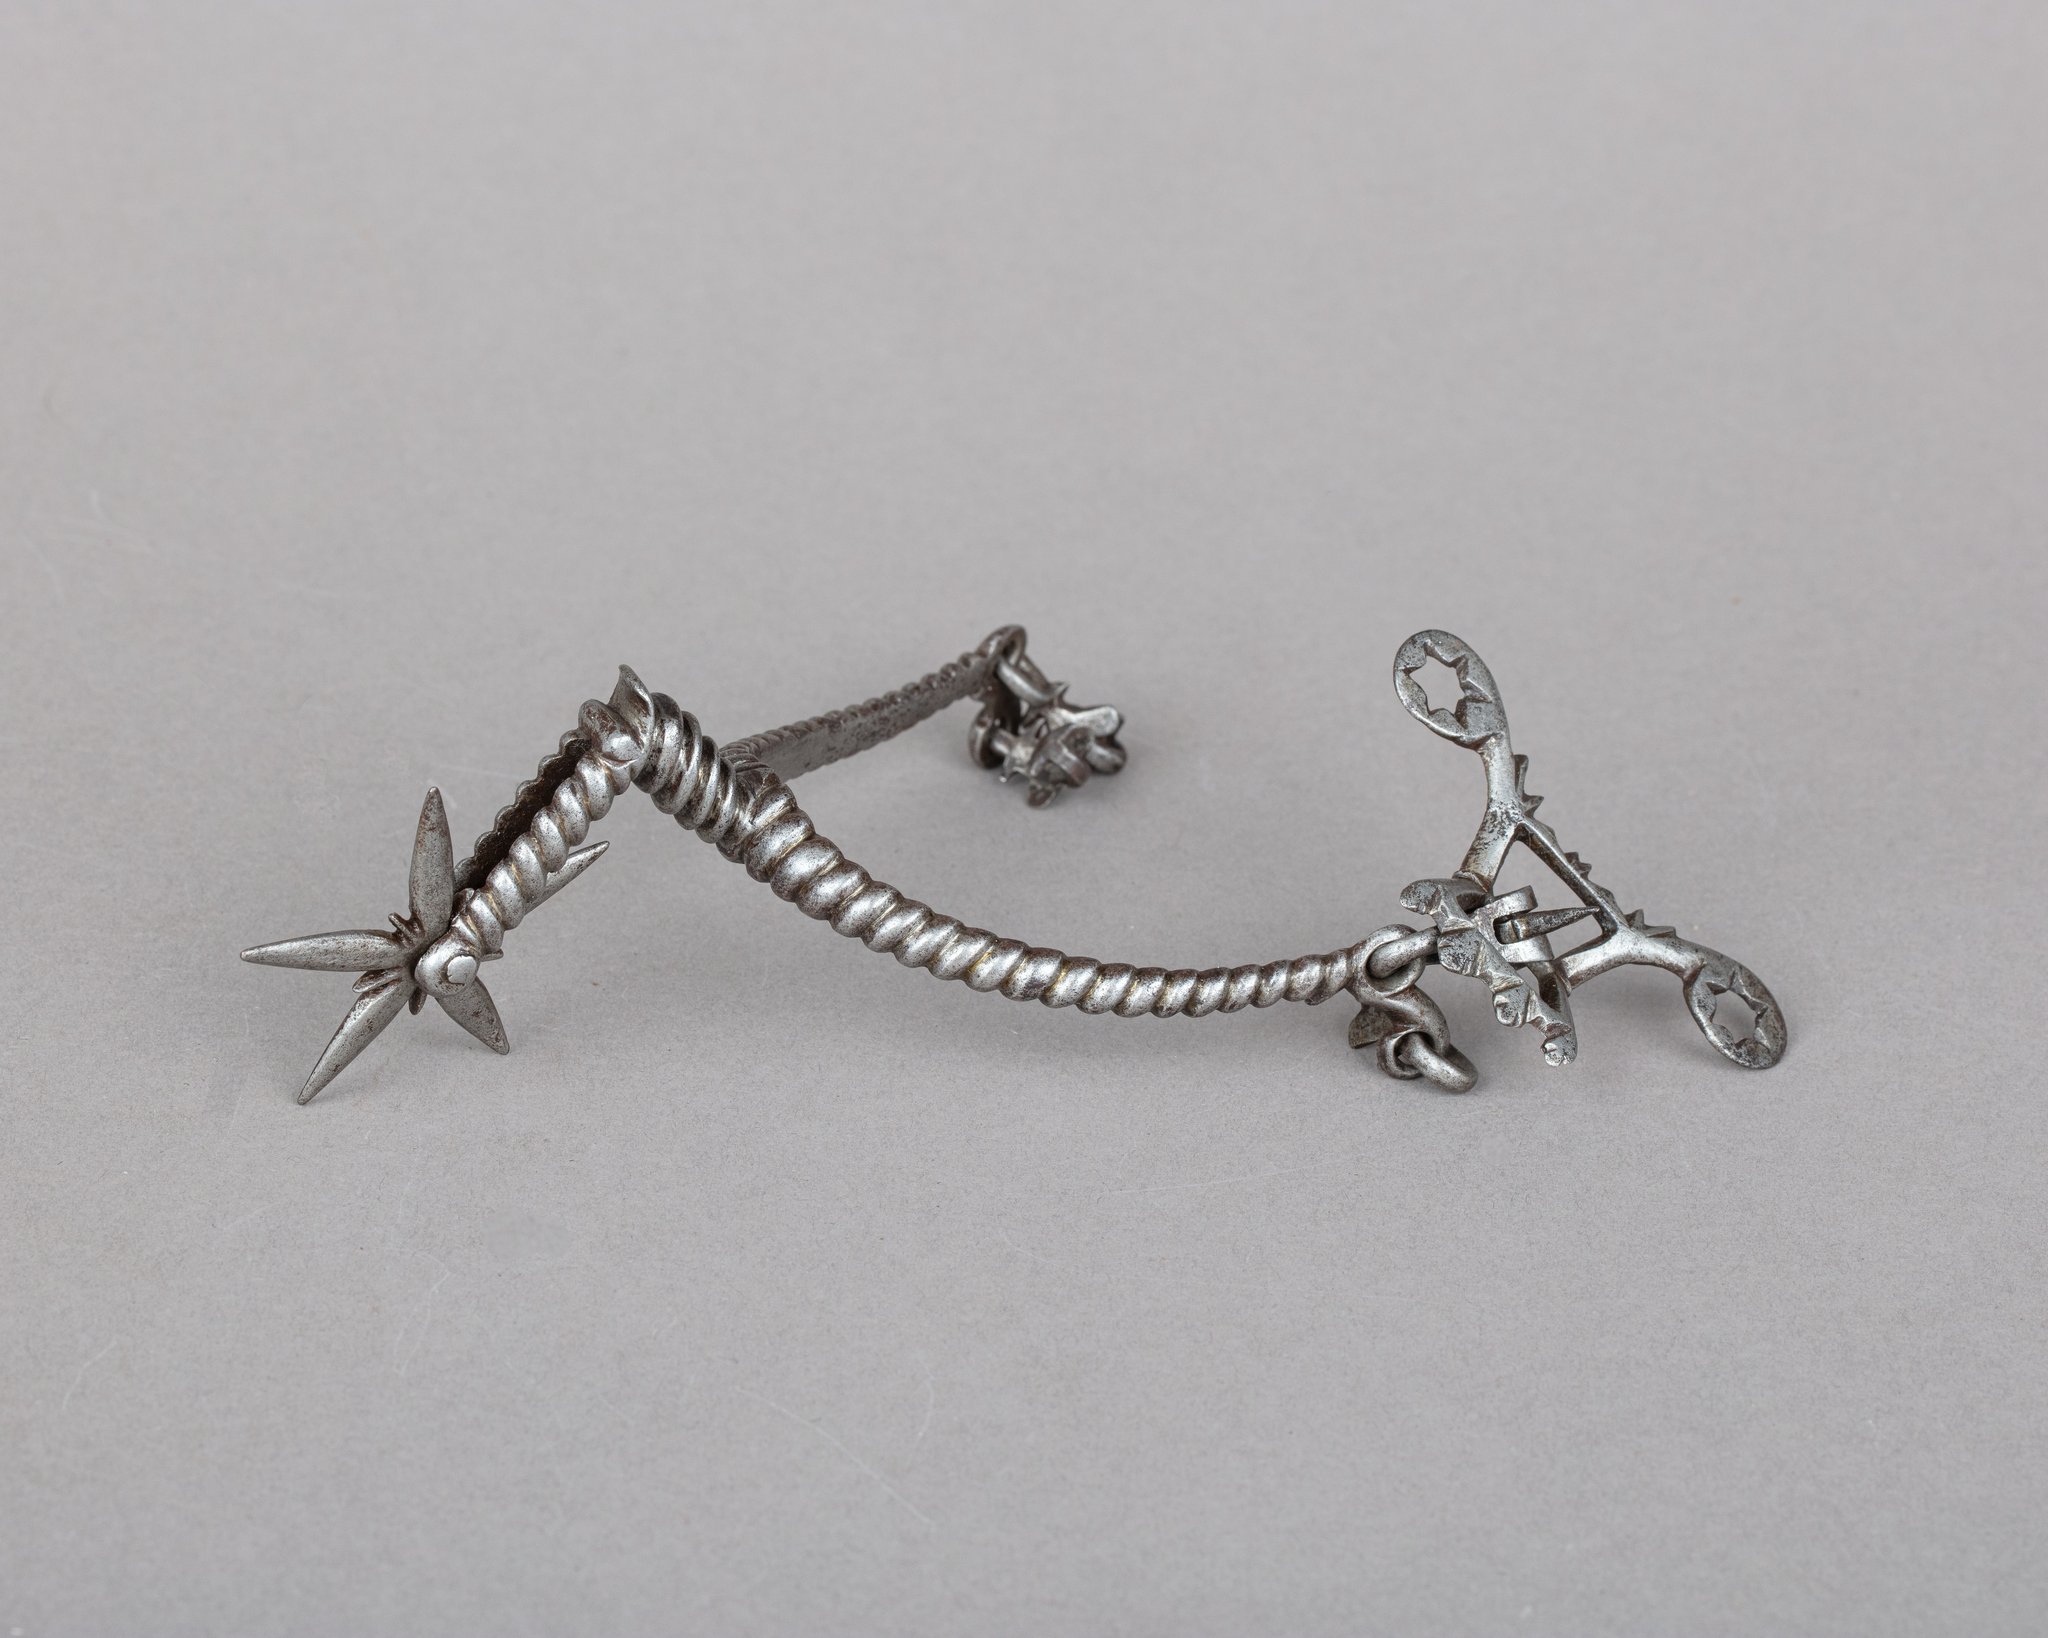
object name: spur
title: Rowel Spur (Right)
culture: german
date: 1630-1660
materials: metal alloy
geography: germany